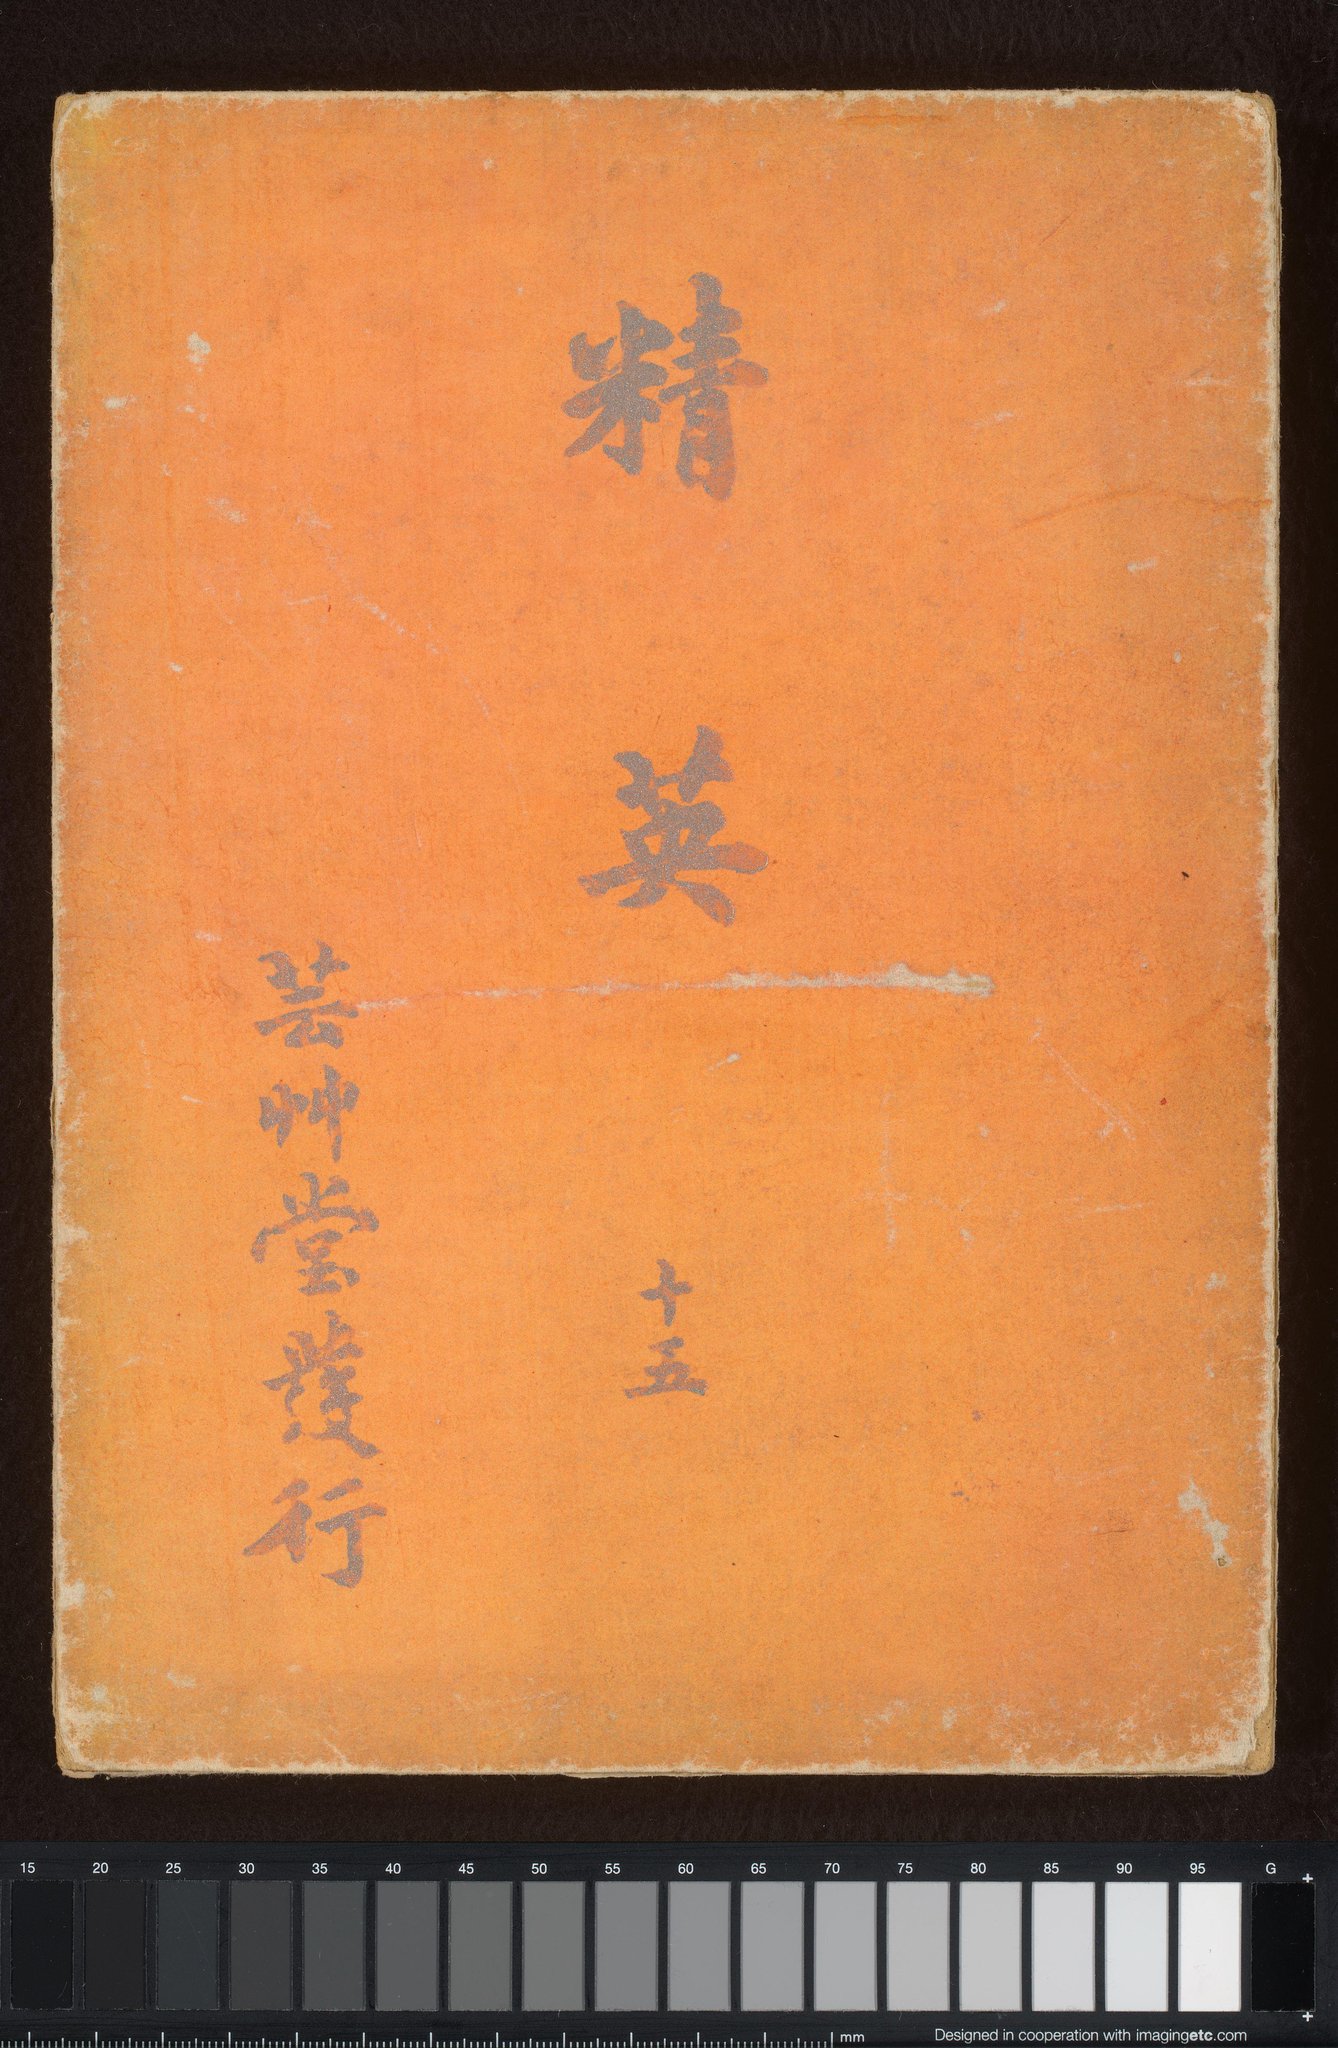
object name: book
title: Stofontwerpen - deel 15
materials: gold powder, paper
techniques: woodcut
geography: japan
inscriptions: date